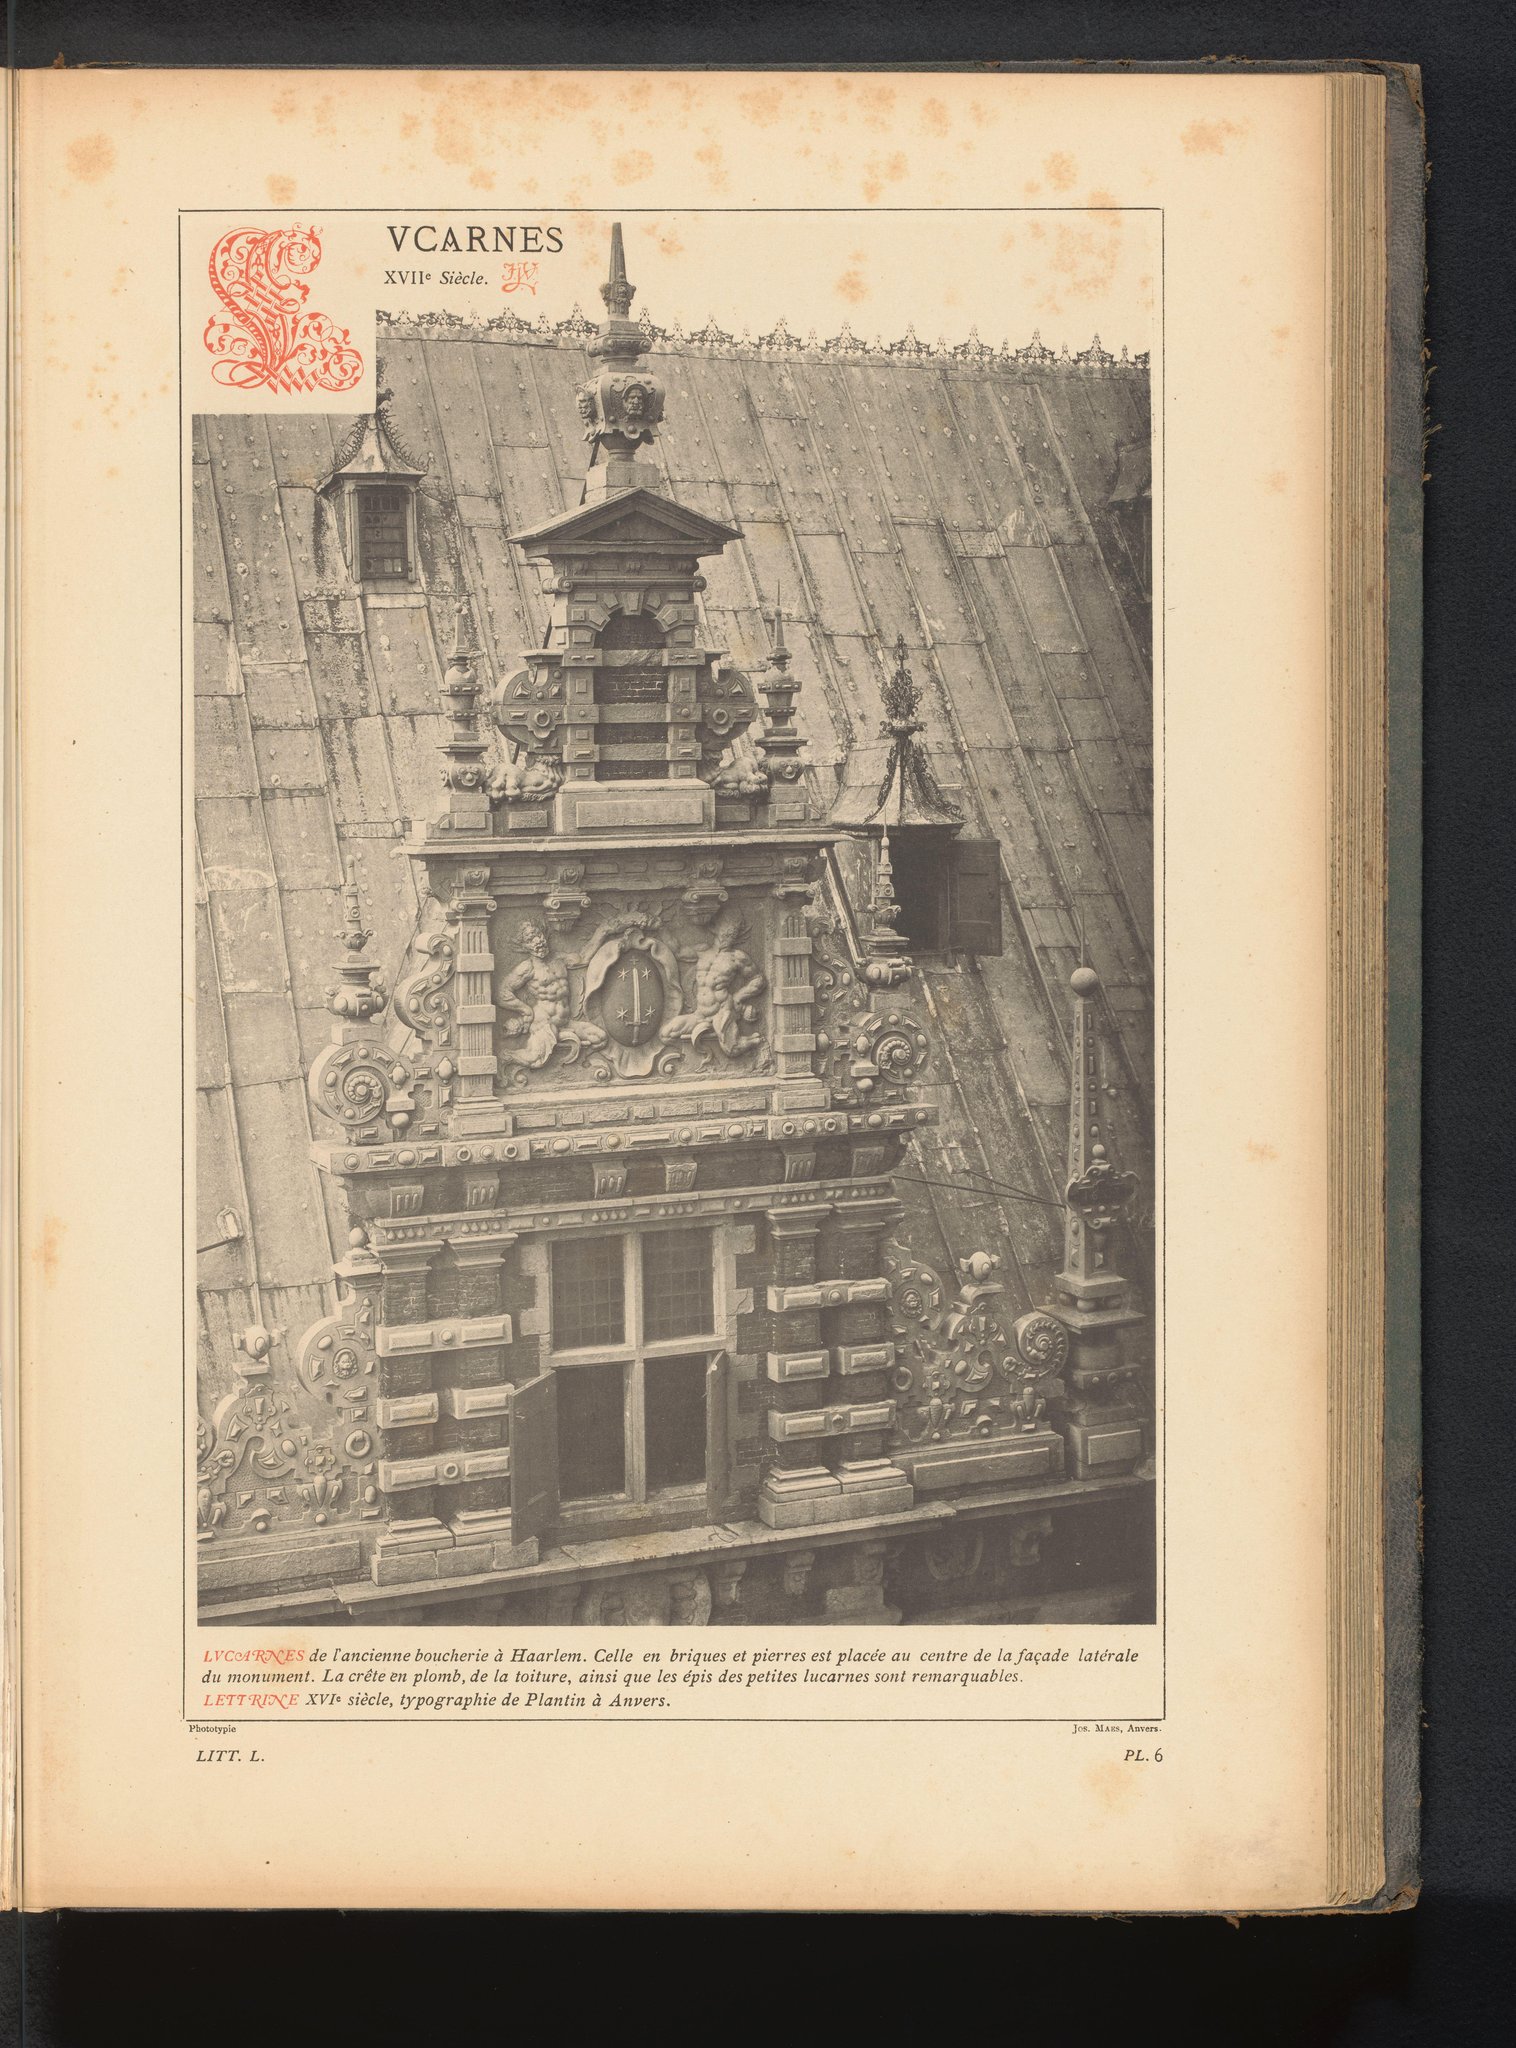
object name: page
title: Lucarnes, XVIIe Siècle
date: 1875-1880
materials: paper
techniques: photograph, photolithography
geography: antwerp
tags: roof (of house or building), window, haarlem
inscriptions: inscription: ‘LITT. L. - PL. 6’, inscription: ‘LUCARNES de l'ancienne (...)’, monogram: ‘JJvY’